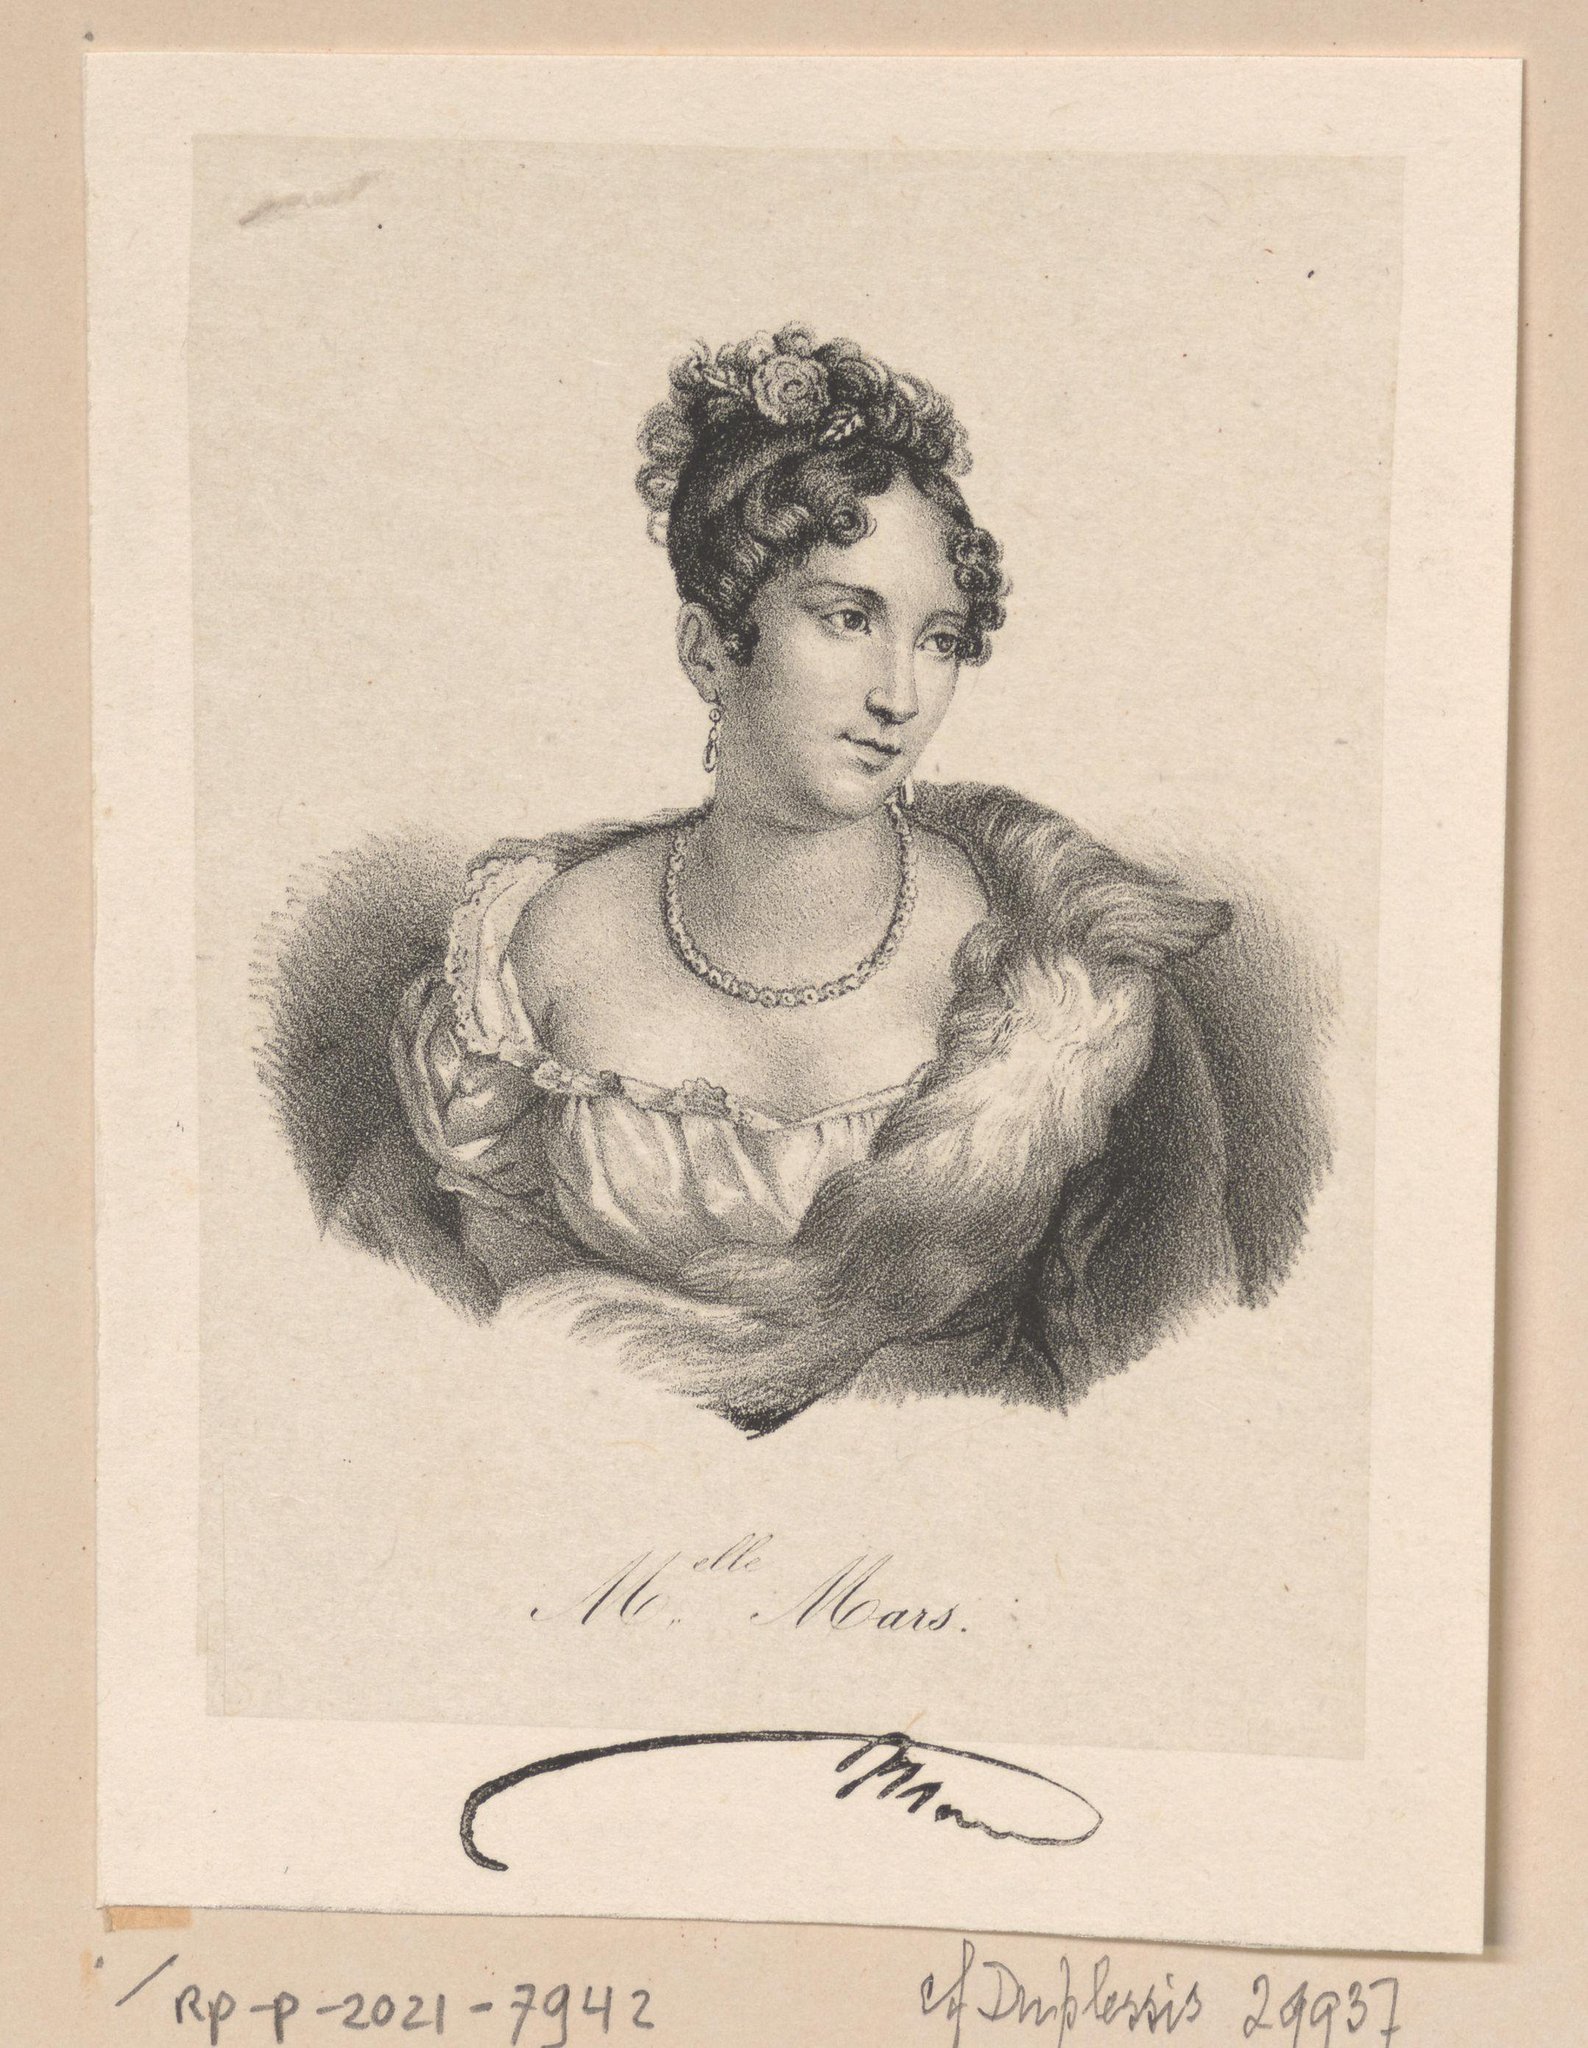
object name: print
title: Portret van Mademoiselle Mars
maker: Anonymous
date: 1800-1850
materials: paper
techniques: lithograph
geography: france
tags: historical persons - bb - woman, portrait of actor, actress